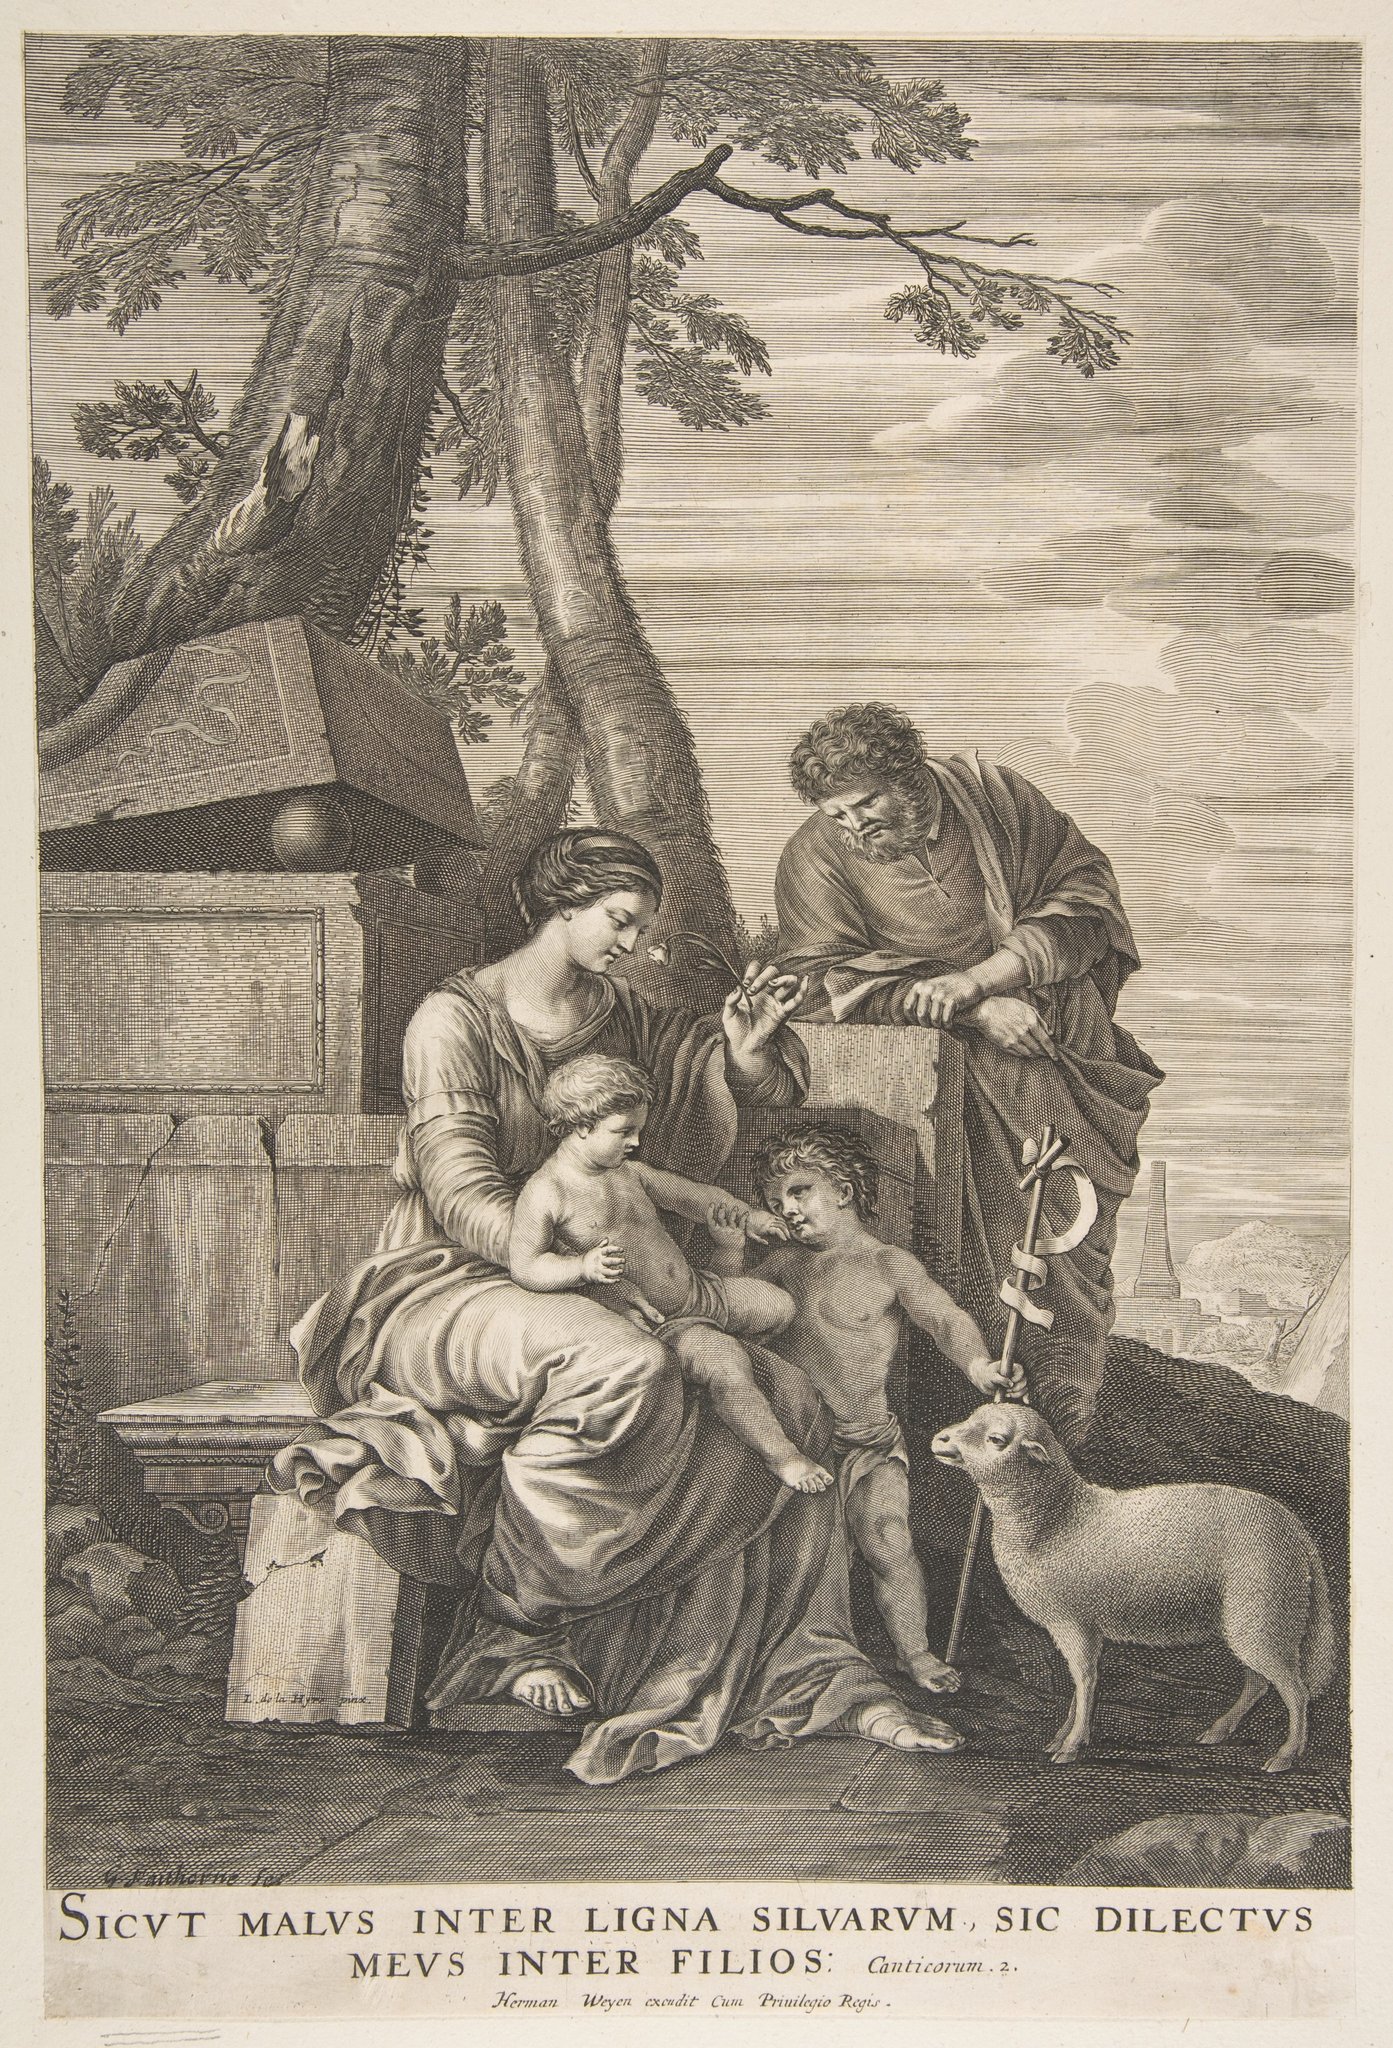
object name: print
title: Holy Family with St. John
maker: william faithorne the elder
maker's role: artist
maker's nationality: british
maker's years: 1615-1691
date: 1655-1672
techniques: engraving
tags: sheep,holy family,saint john the baptist